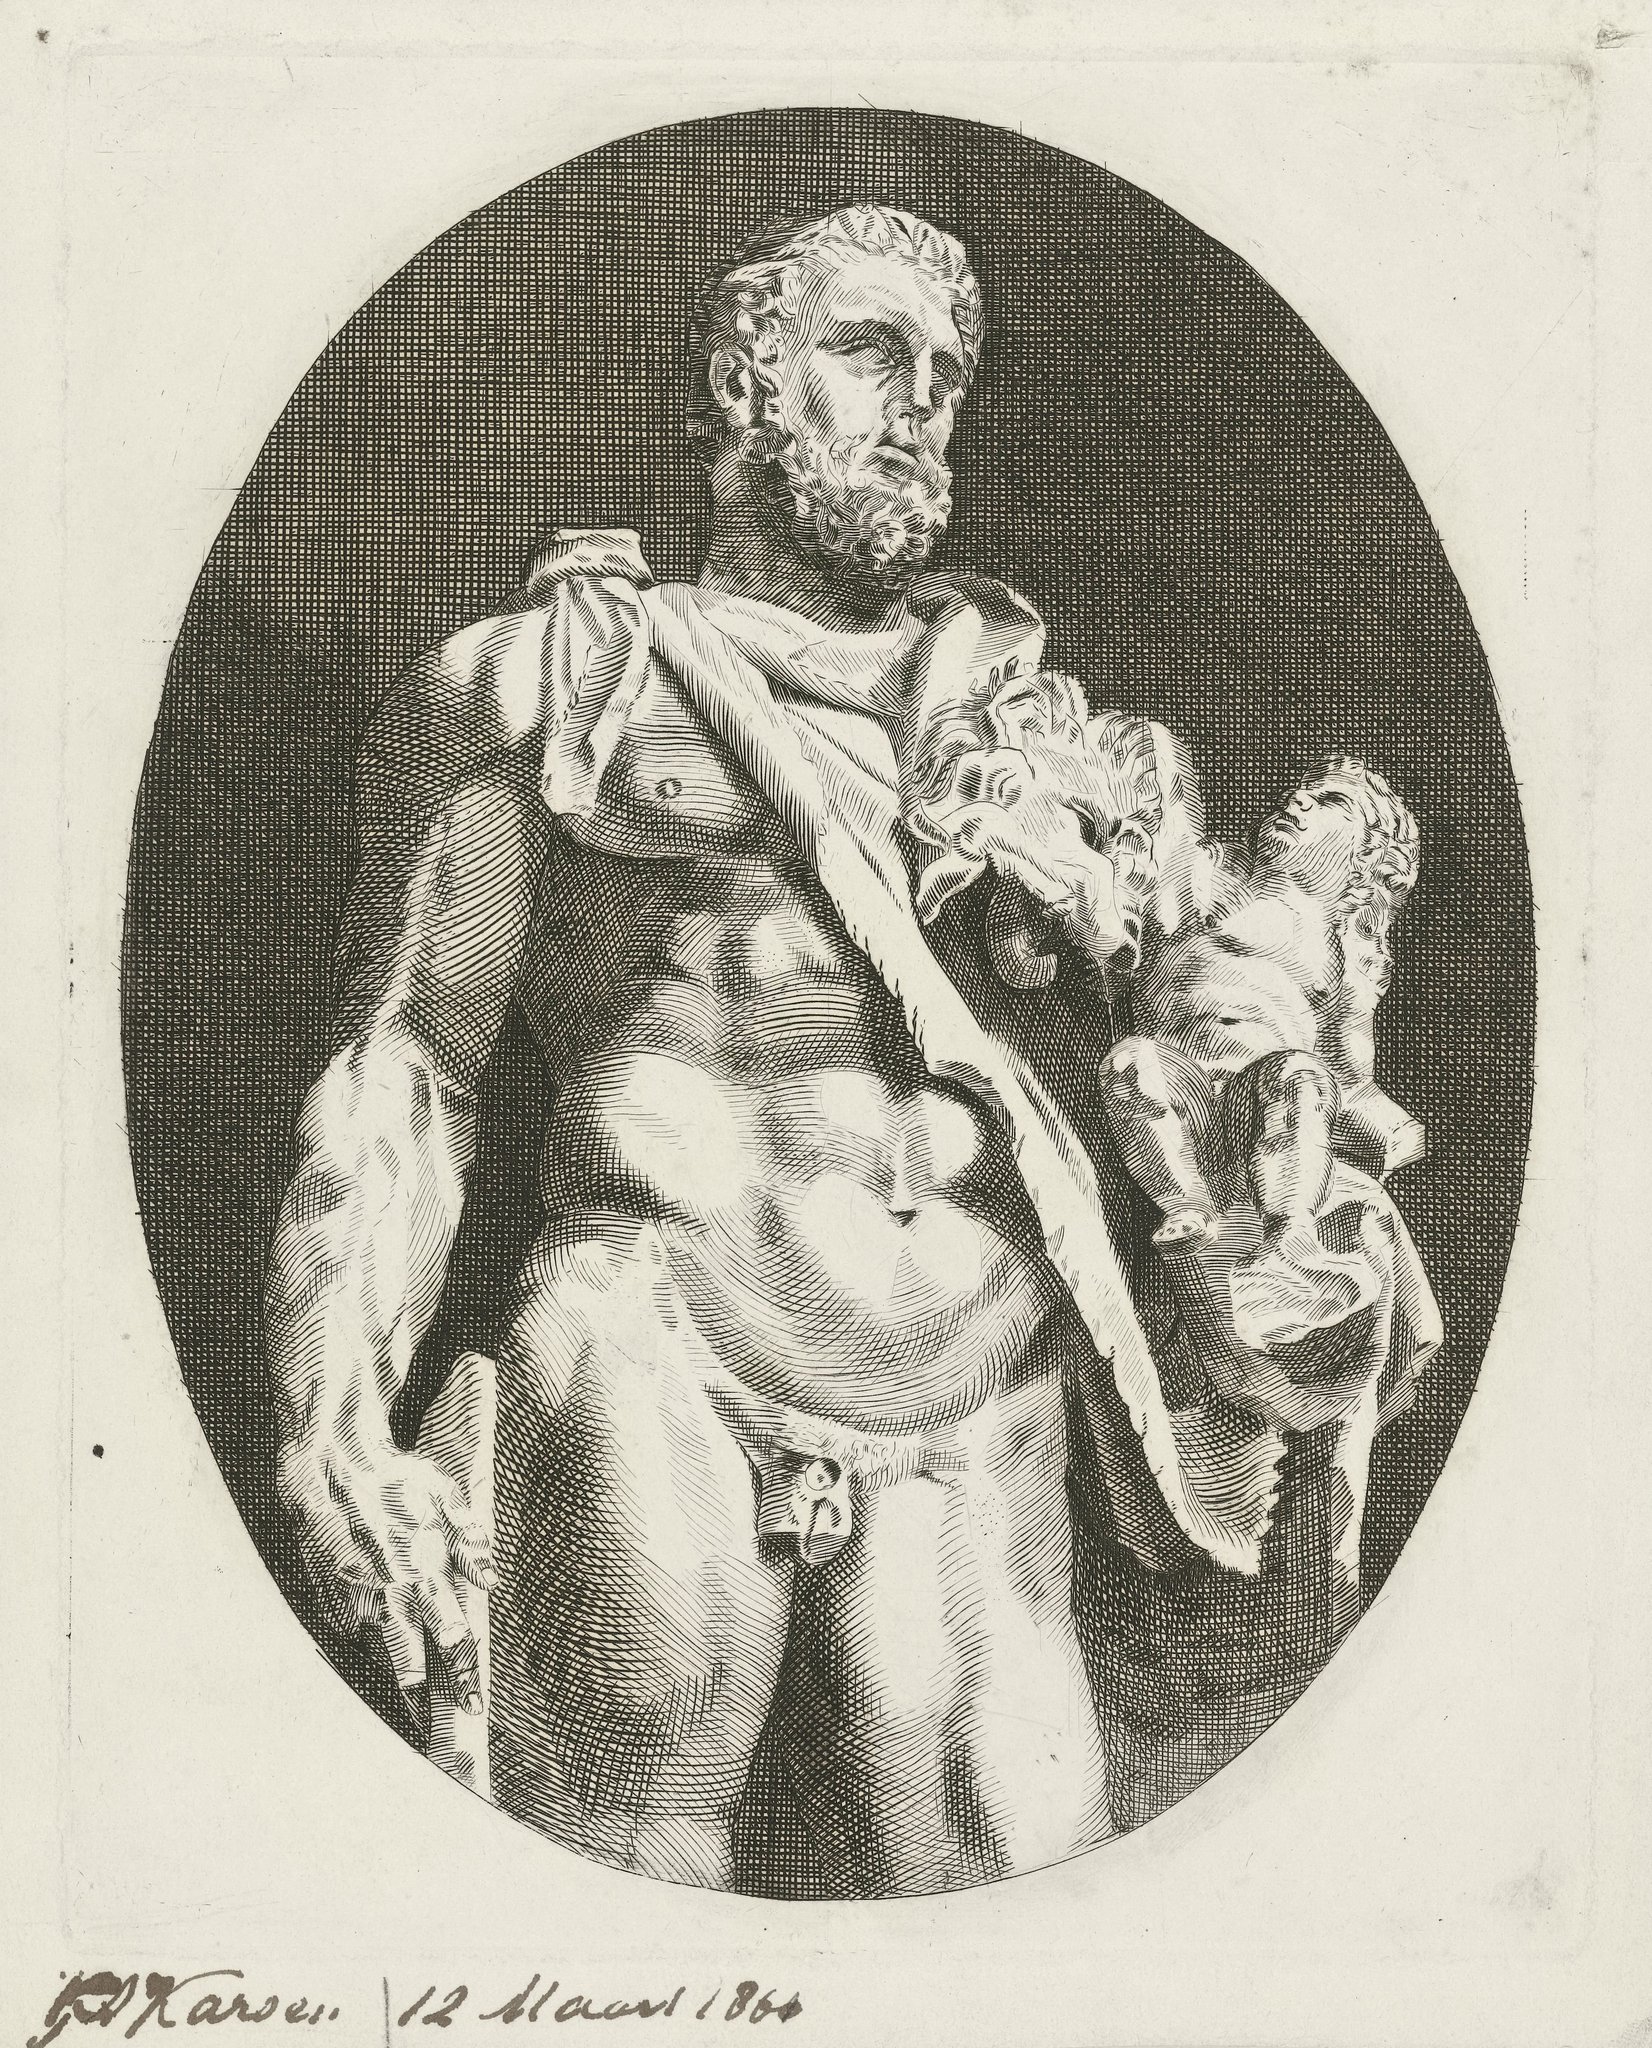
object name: print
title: Hercules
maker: george andries karsen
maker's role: print maker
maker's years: 1843-1912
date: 1860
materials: paper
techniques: engraving, etching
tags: (story of) hercules (heracles)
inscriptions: inscription: ‘G.A. Karsen 12 Maart 1860’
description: Afbeelding van een standbeeld van Hercules met een kind op zijn arm en een leeuwenvel over zijn schouder.